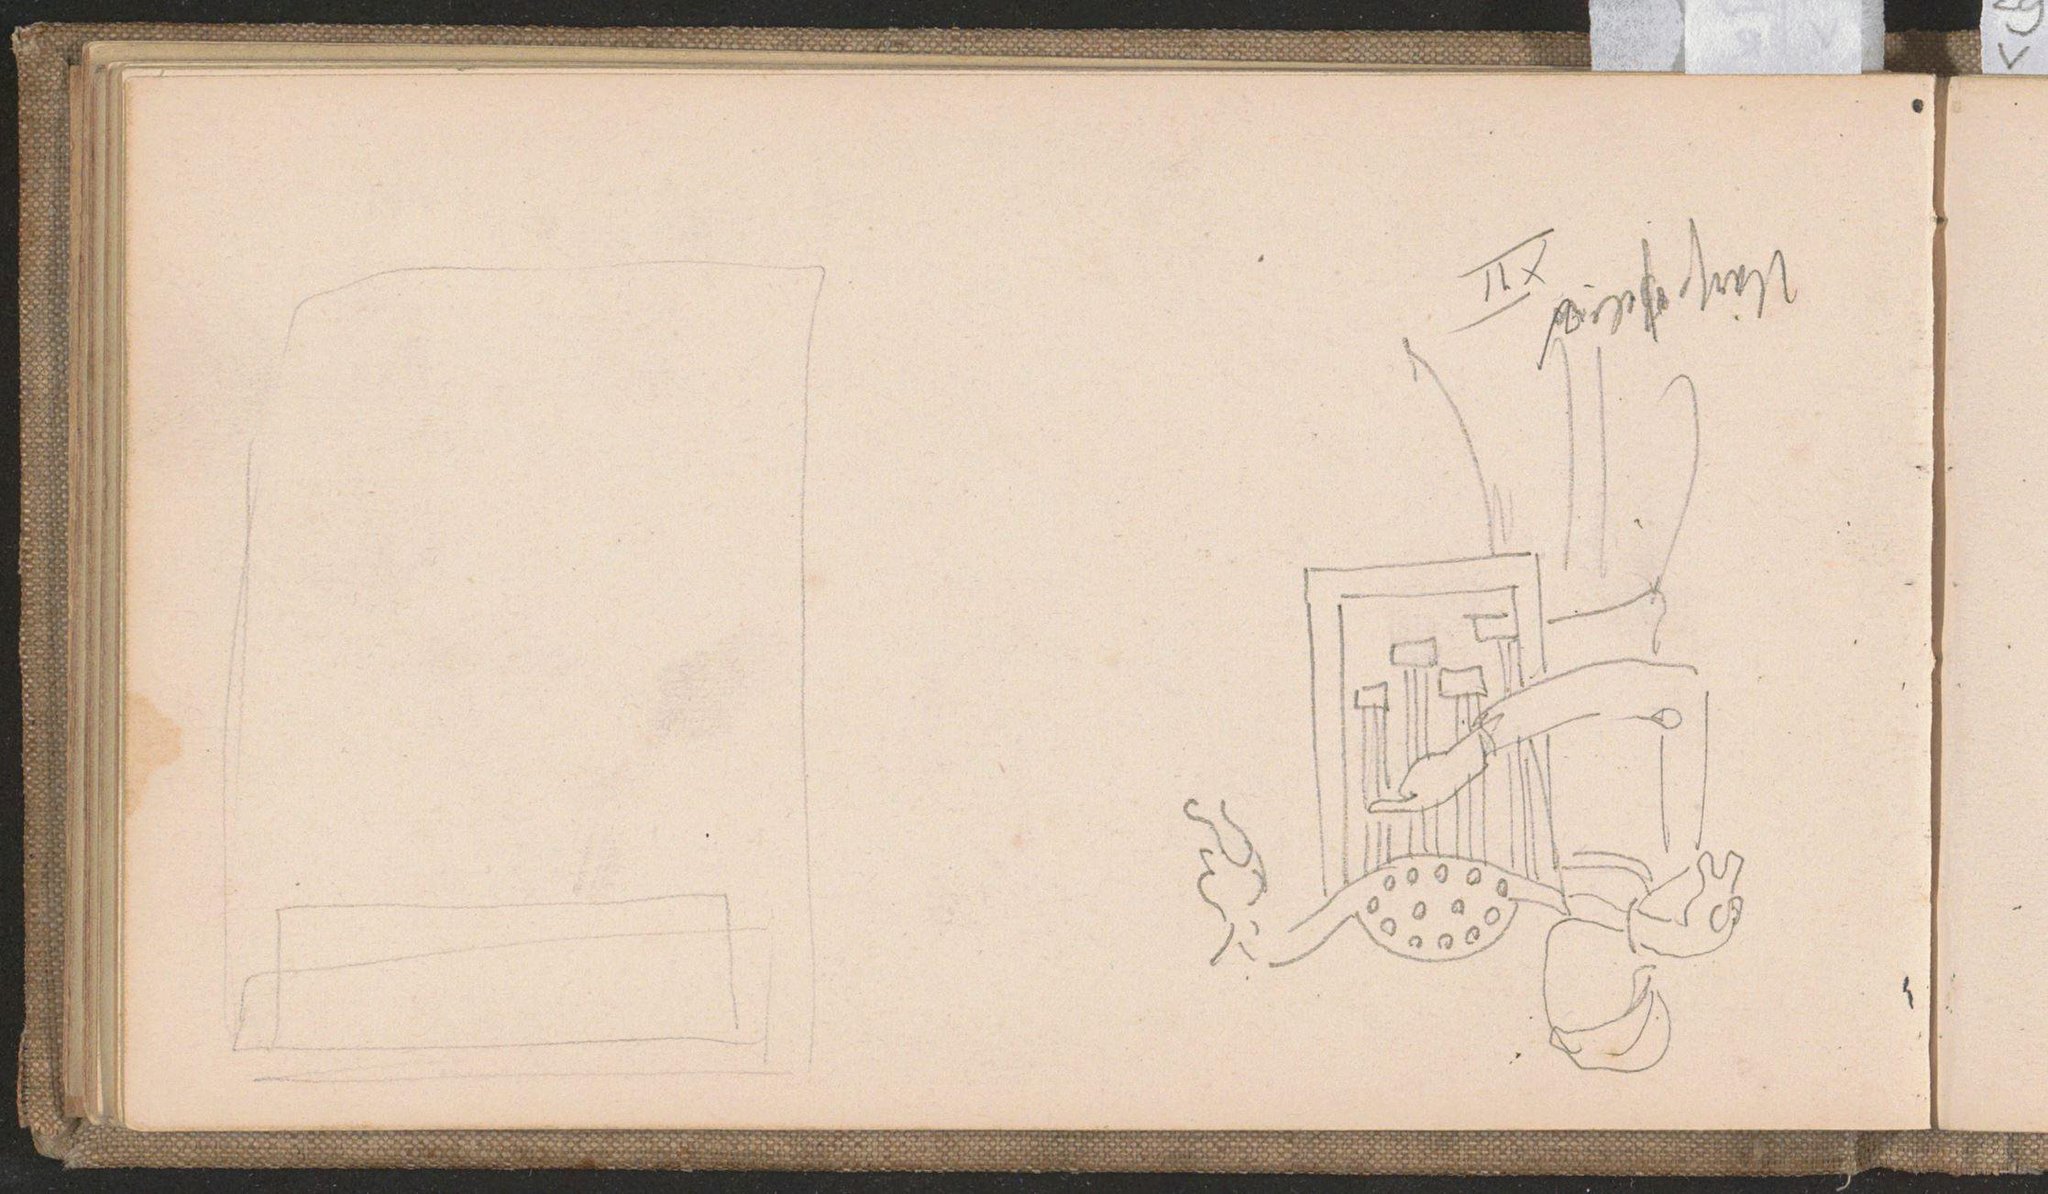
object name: sketchbook leaf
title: Harpspeler, naar een voorbeeld uit de twaalfde eeuw na Christus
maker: antoon derkinderen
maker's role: draughtsman, painter, print maker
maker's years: 1859-1925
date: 1892-1901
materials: paper, pencil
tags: harp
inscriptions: annotation: ‘Harp speler/ XII’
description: Blad 25 verso uit een schetsboek met 51 bladen.